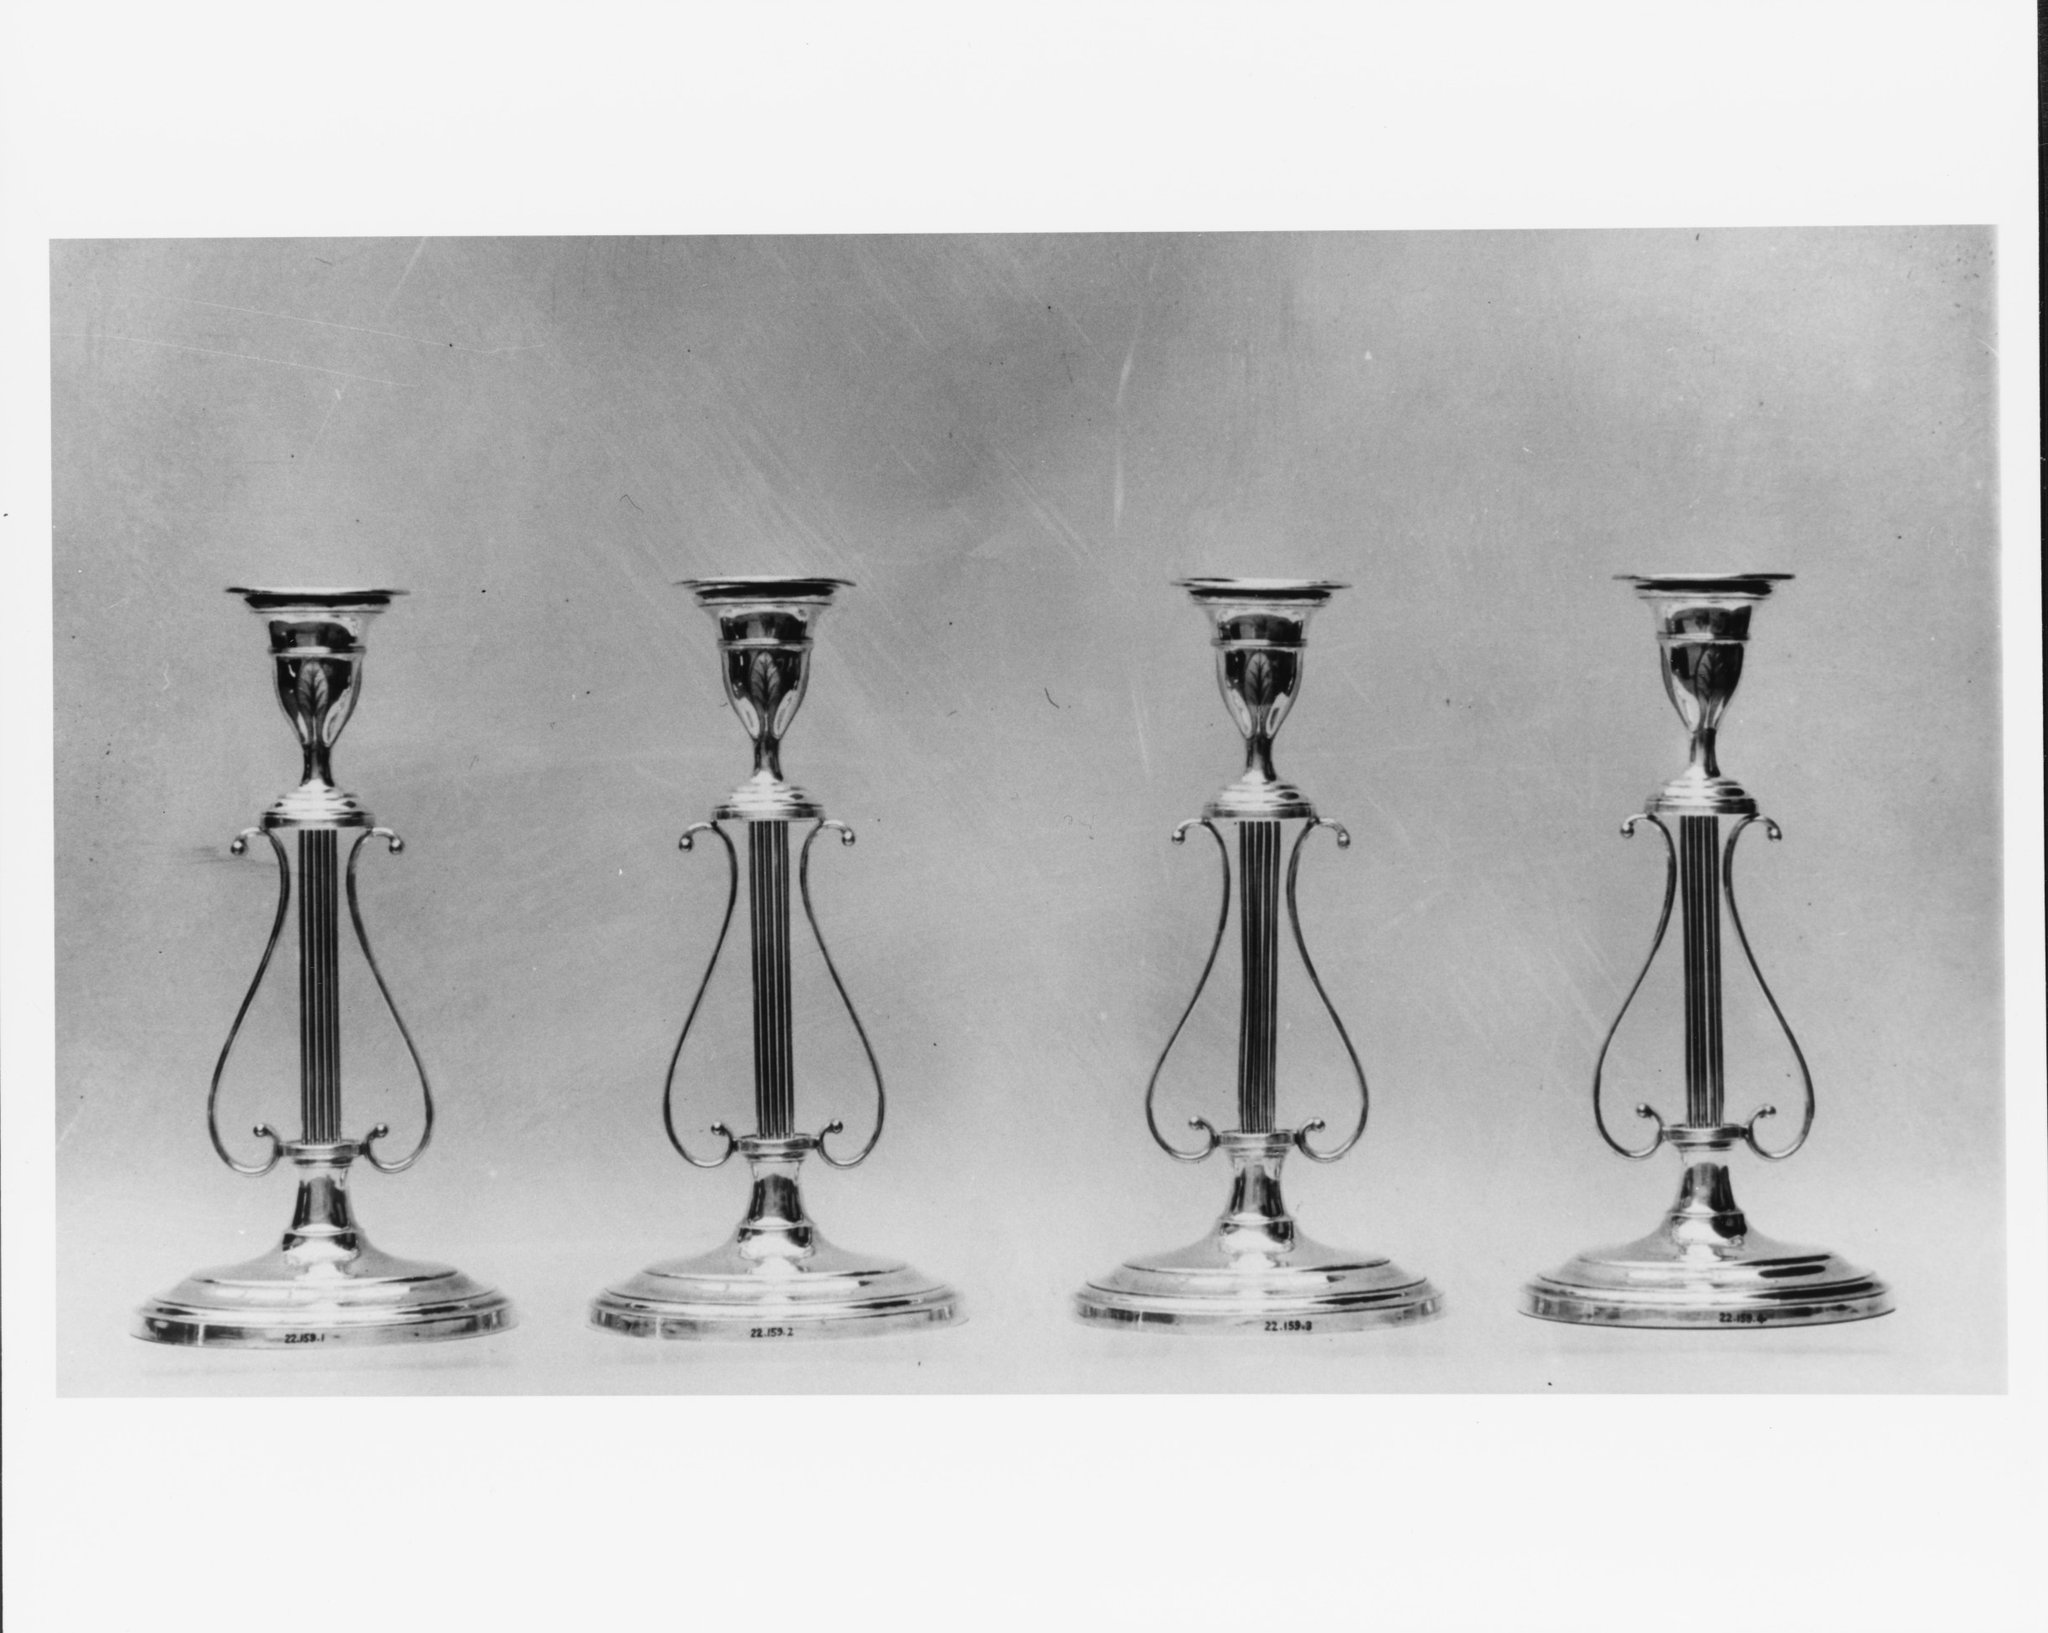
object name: candlestick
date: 1800-1830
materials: copper, silver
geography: england